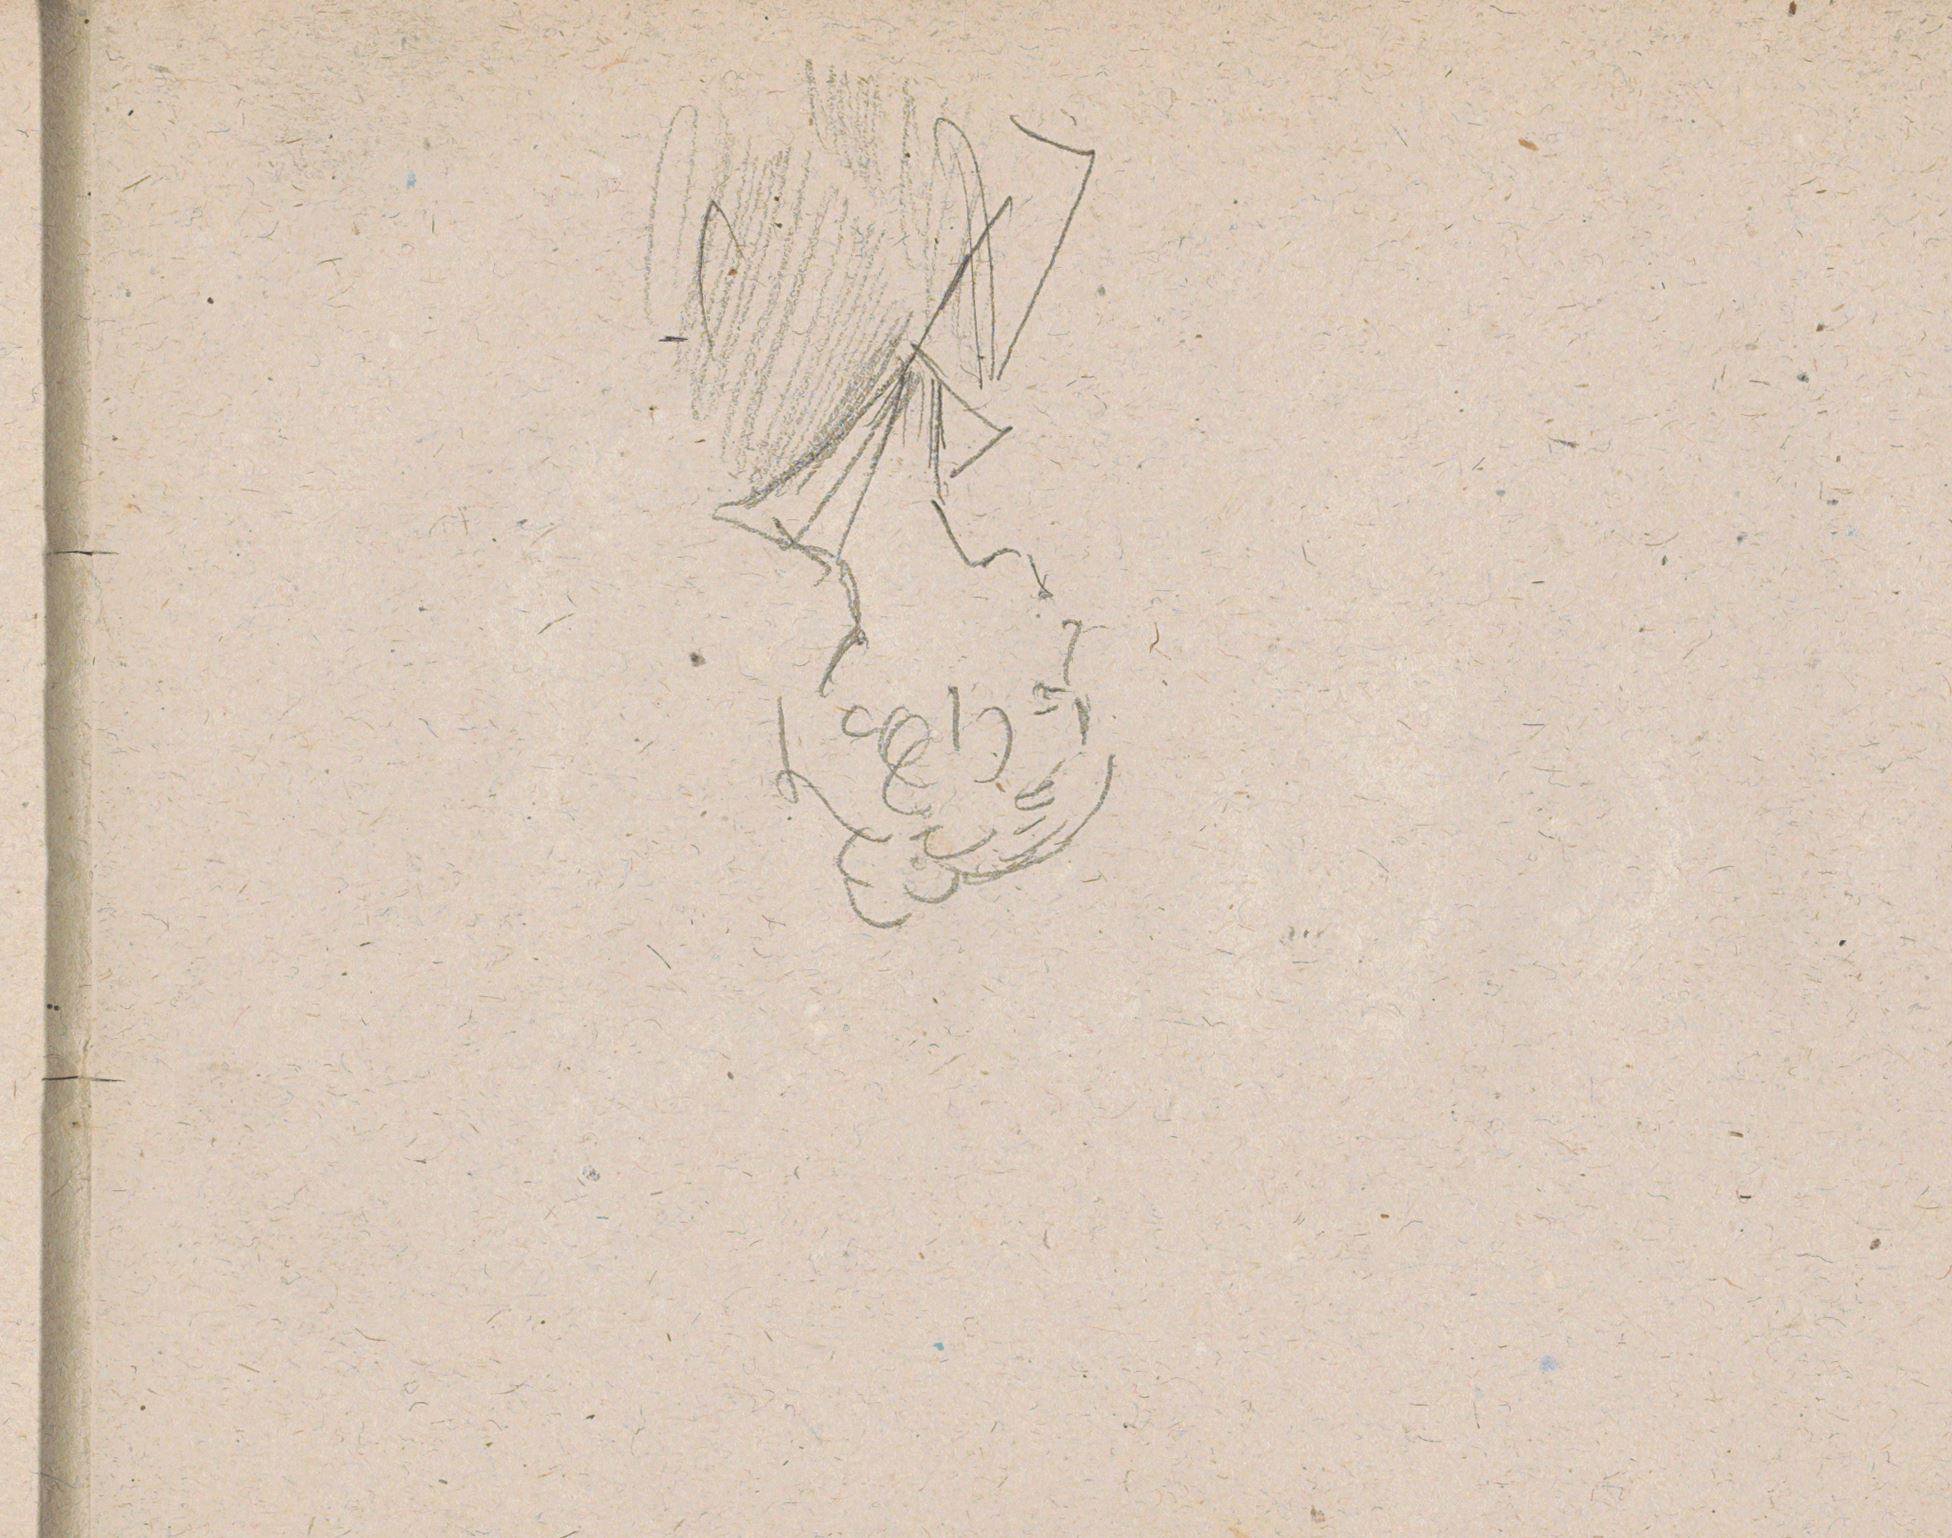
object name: sketchbook leaf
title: Jonge vrouw, in profiel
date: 1919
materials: paper, pencil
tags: adolescent, young woman, maiden (+ sideview, profile)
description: Pagina 10 uit schetsboek XXXV met 36 pagina's.